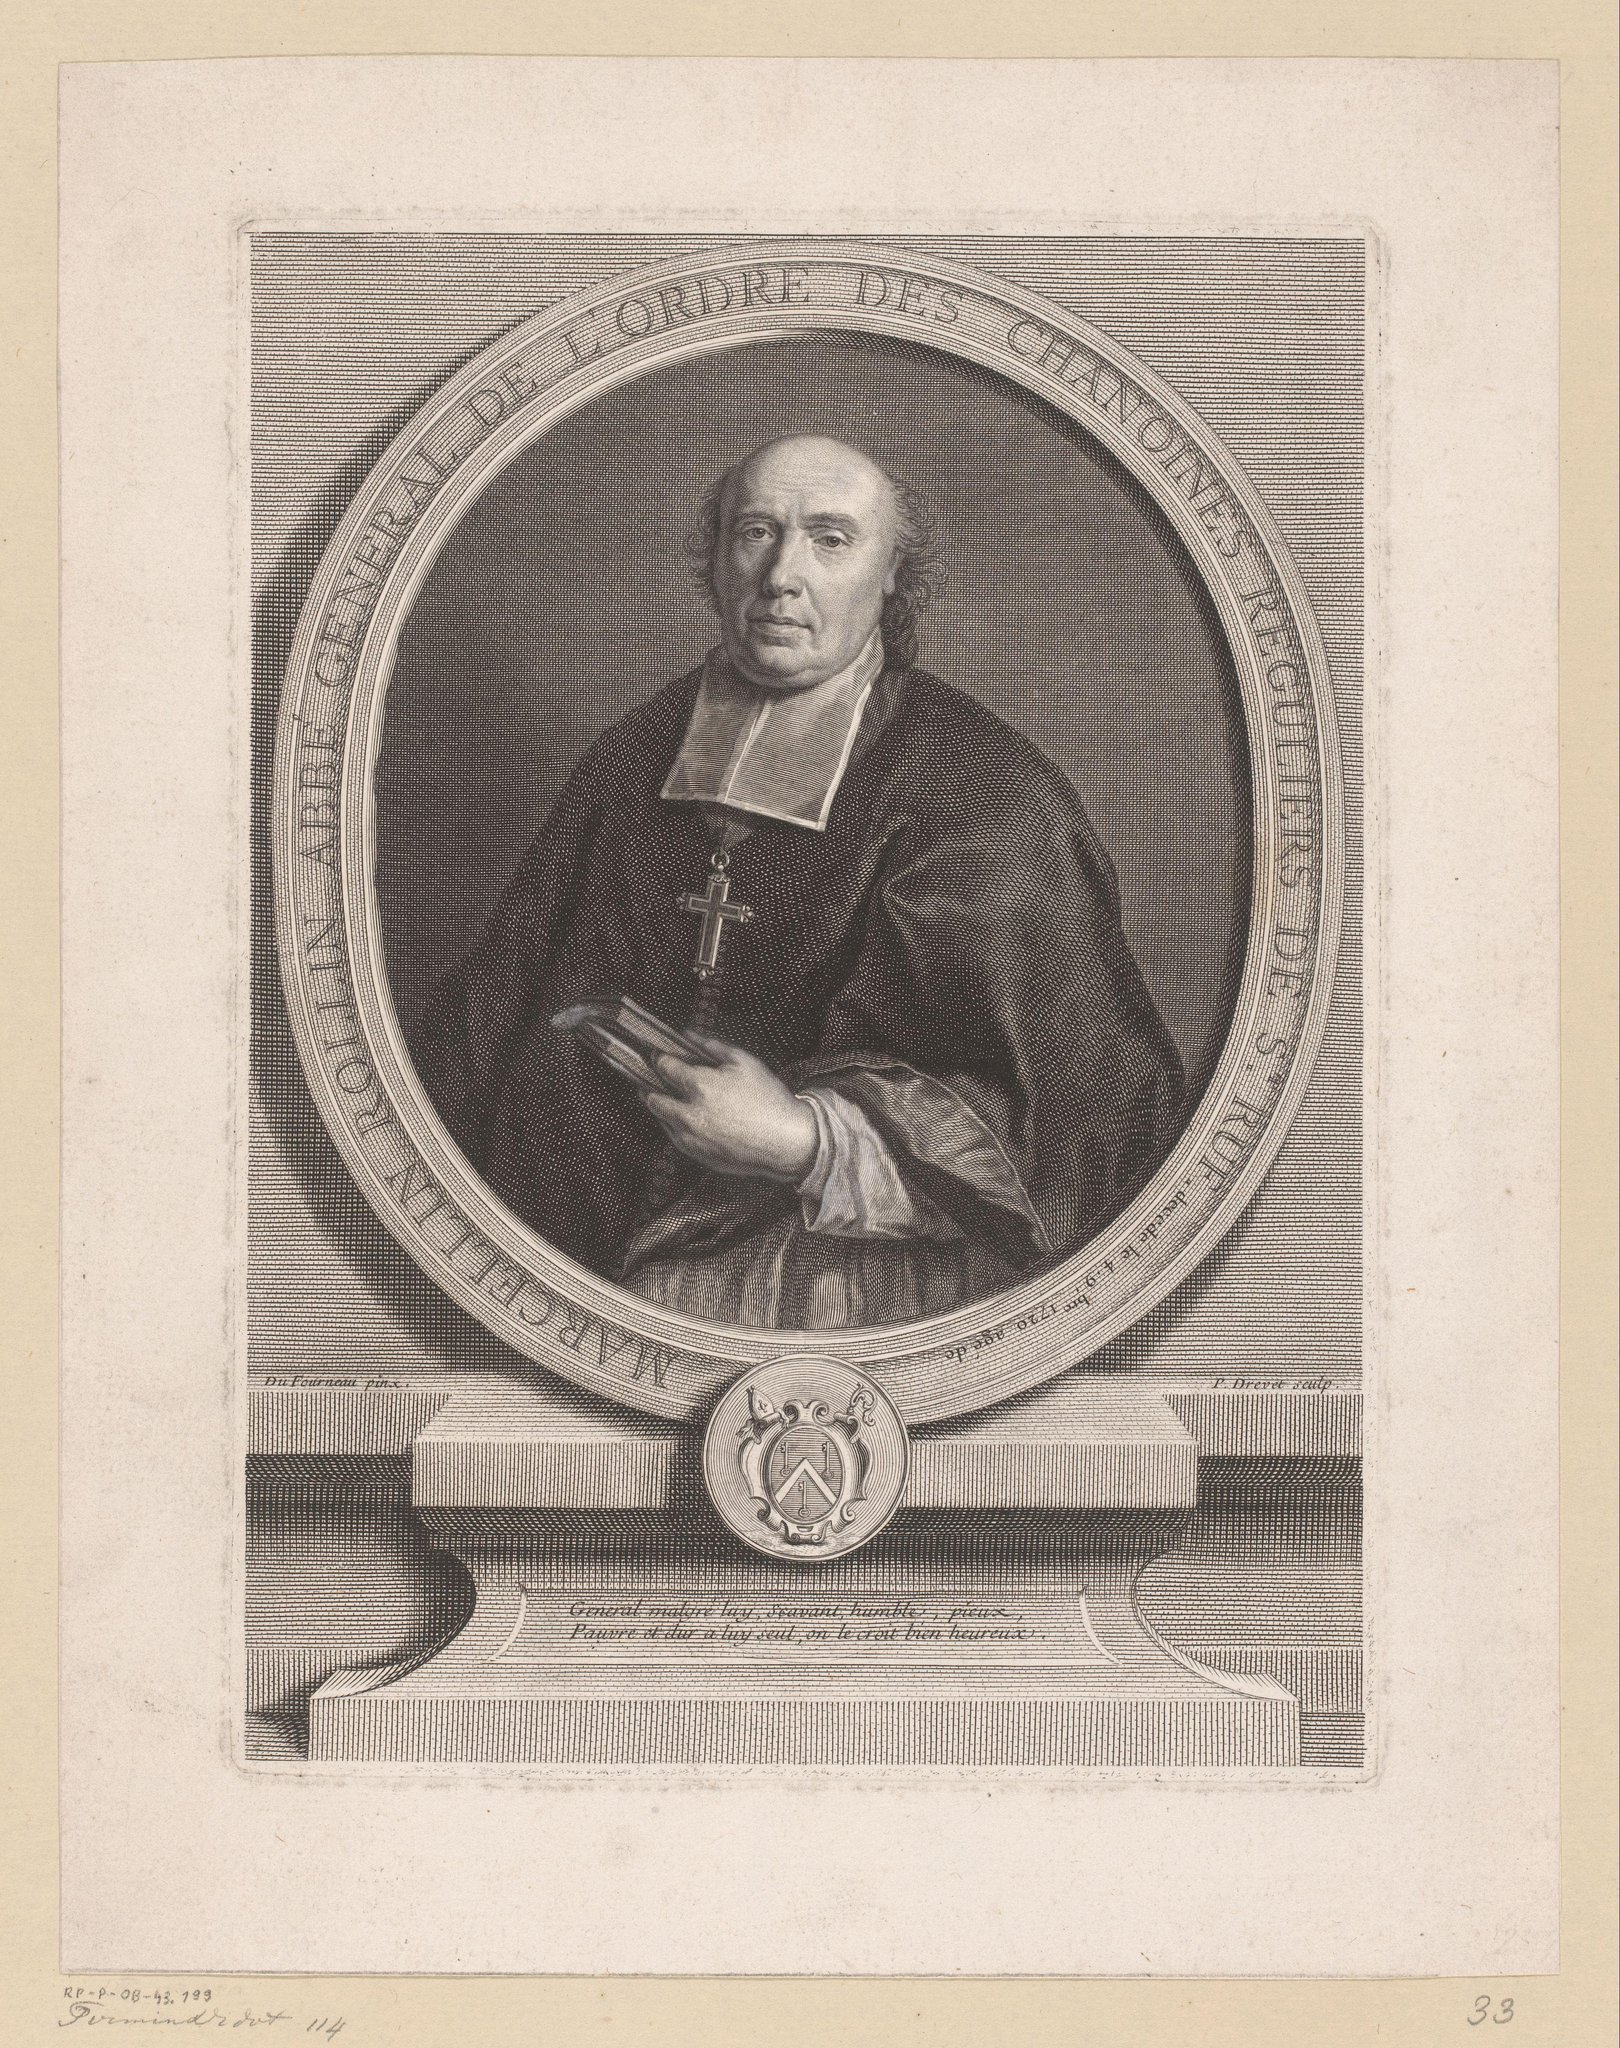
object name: print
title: Marcellin Rollin abbé general de l'ordre des chanoines reguliers de S. Ruf.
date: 1720-1738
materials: paper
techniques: engraving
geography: france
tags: ornament ~ medallion, historical persons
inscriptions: collector's mark: Lugt 240